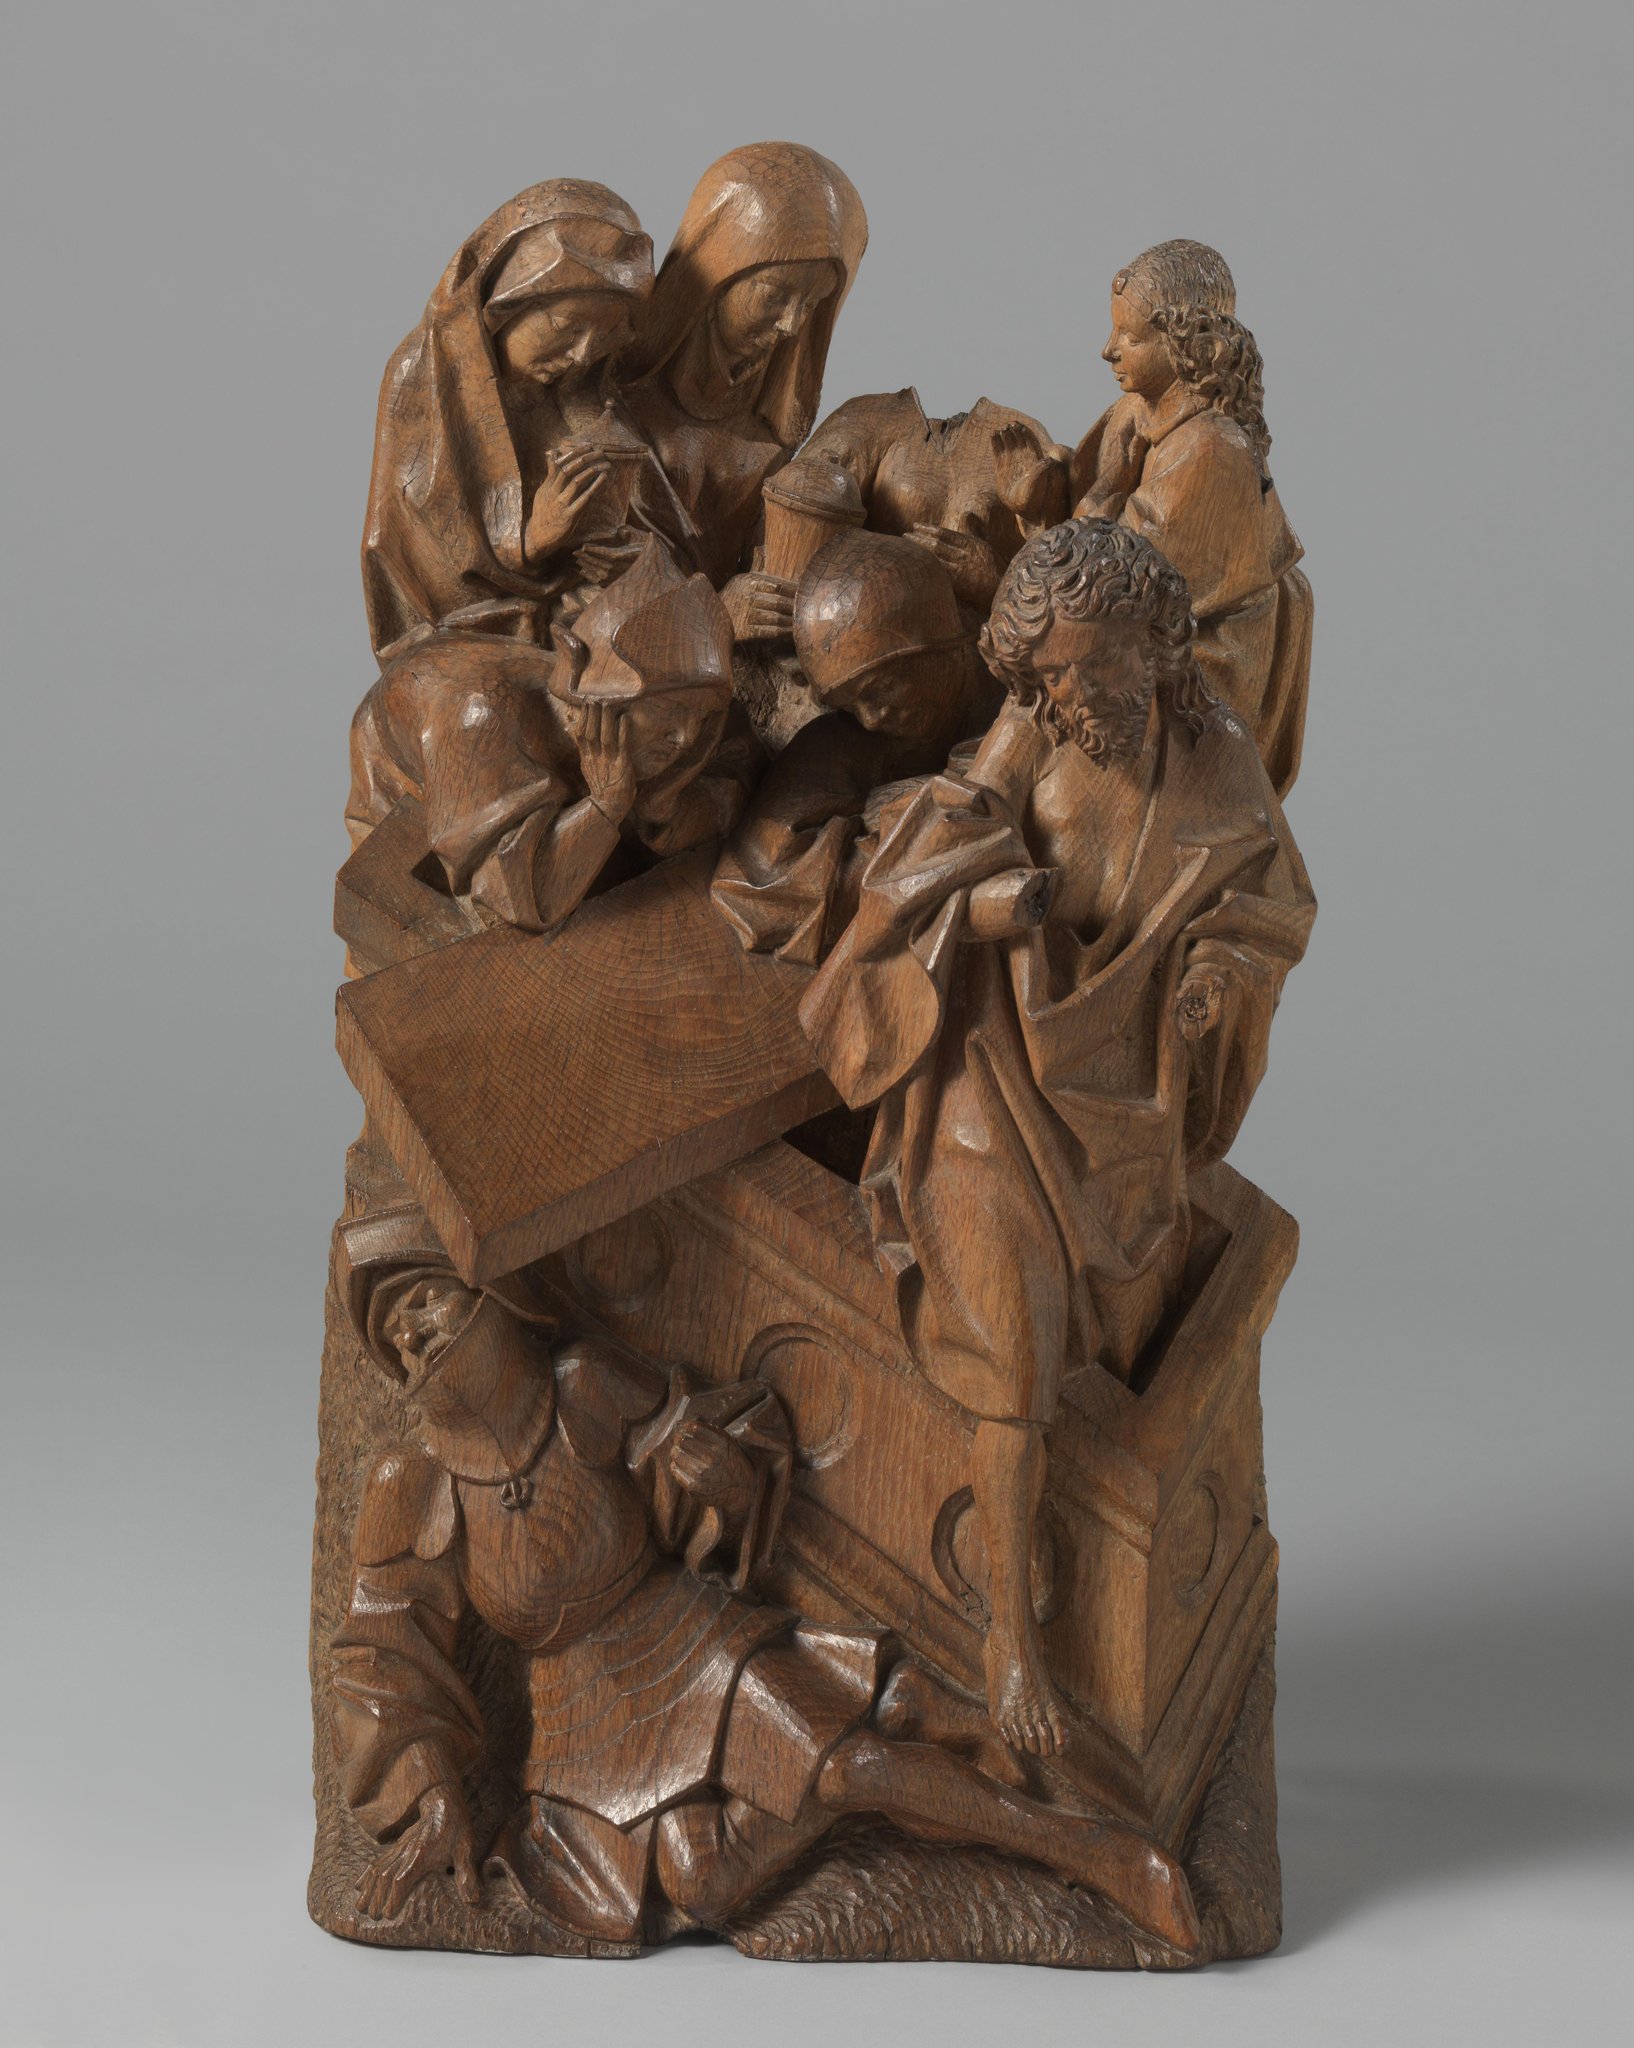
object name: sculpture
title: The Resurrection and the Three Marys at the Sepulchre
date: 1460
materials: wood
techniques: carved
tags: the holy women (the three maries) on their way to or at the tomb, to anoint christ's body, christ stepping out of the tomb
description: The woodcarver here combined in one scene two separate episodes from the Passion of Christ: his resurrection from the tomb, and the three women – Mary Magdalene, Mary the Mother of Jesus and Mary Salome – who went to the tomb (shown at centre) to embalm his body. A Roman soldier is asleep in front of the tomb.